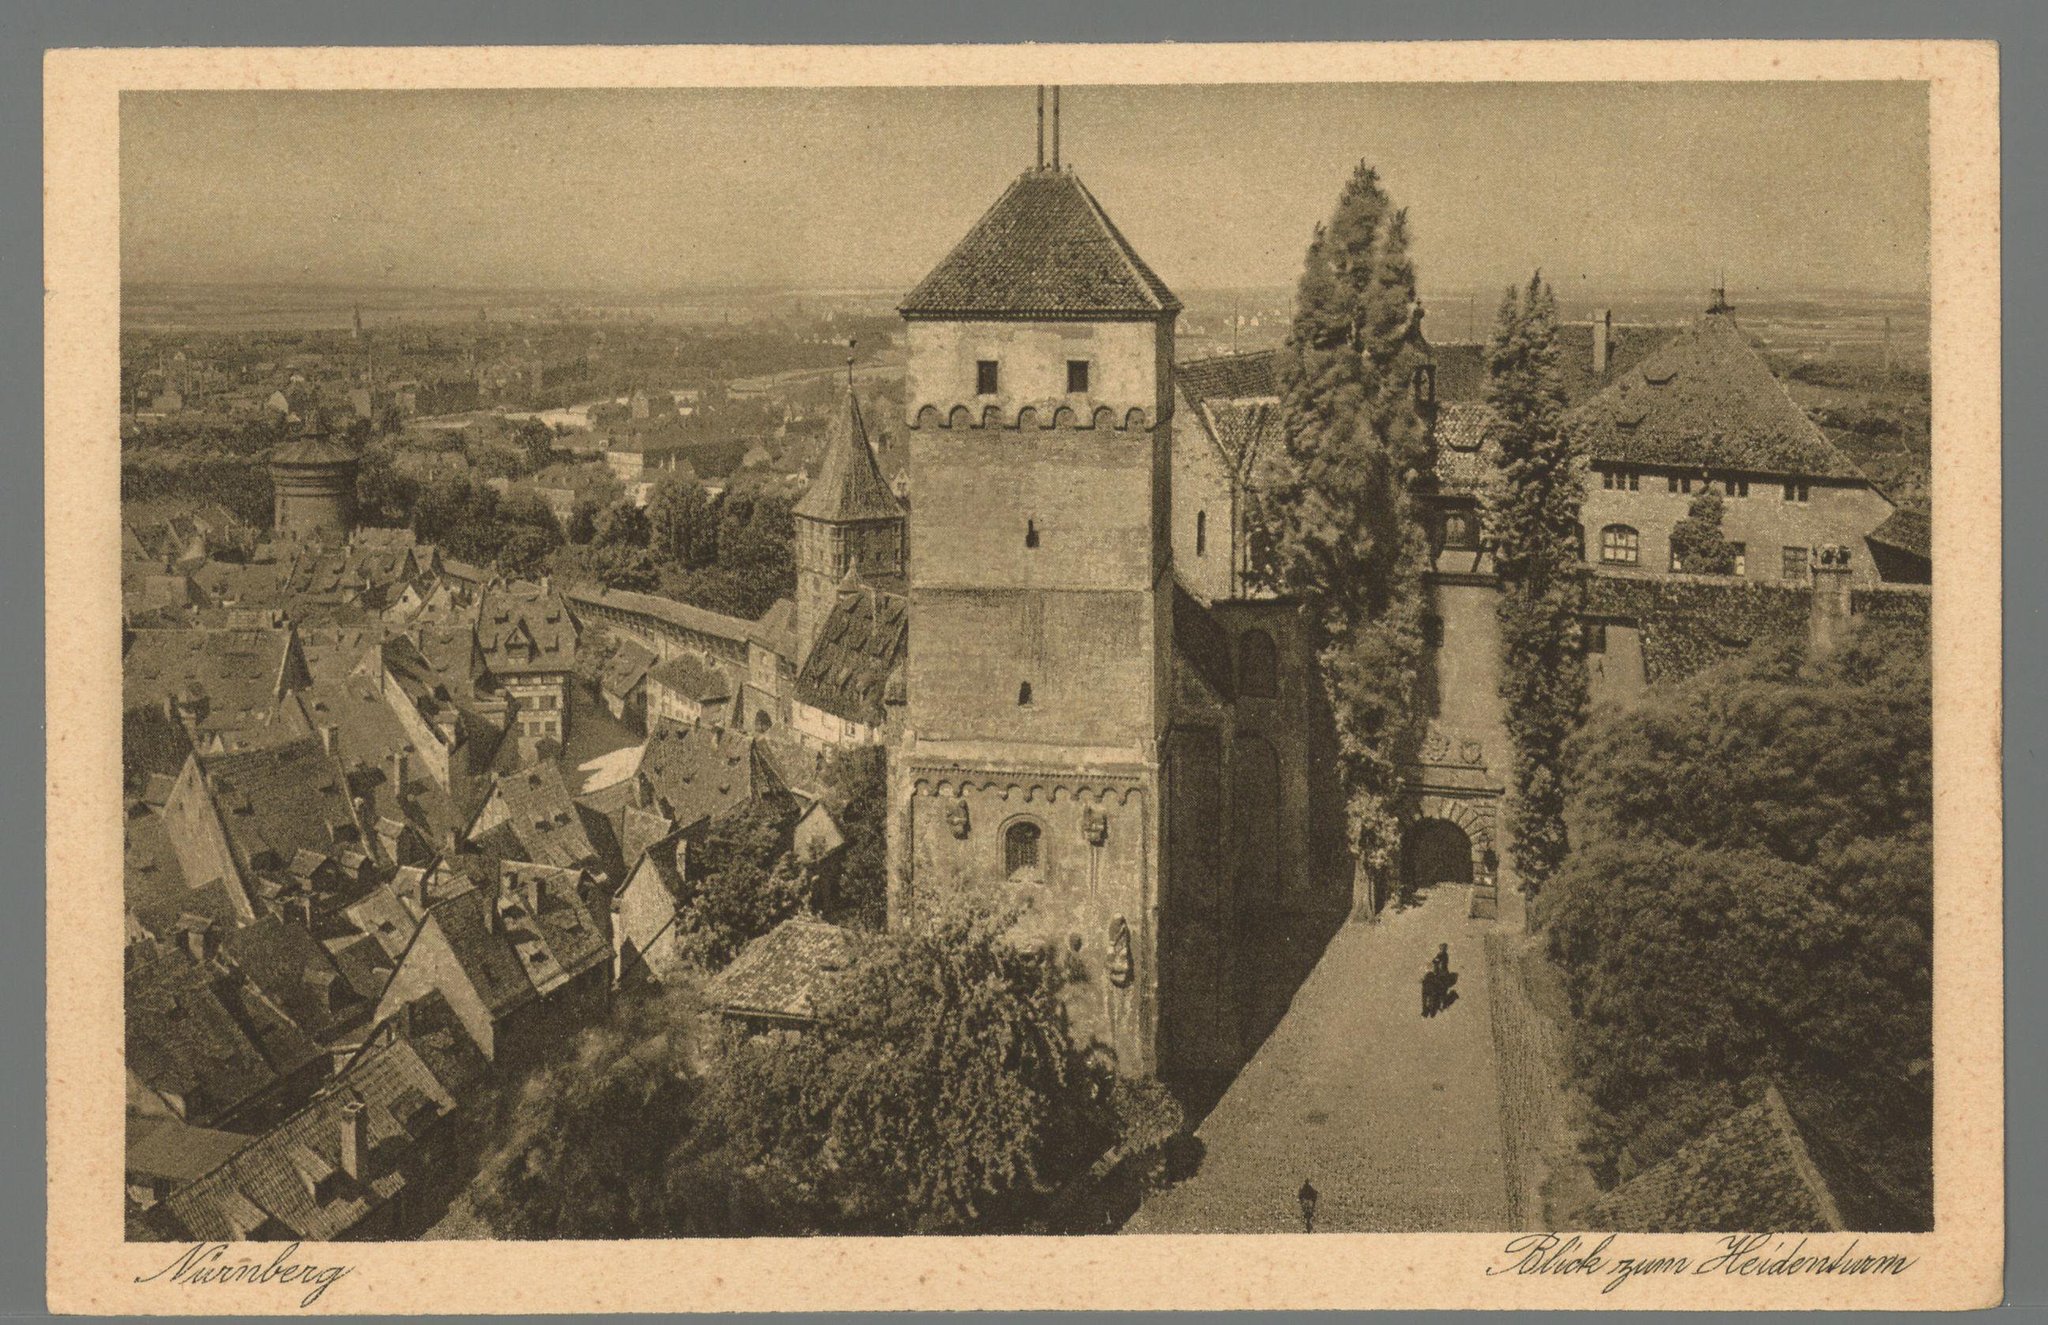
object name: ansichtkaart, prentbriefkaart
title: Nürnberg. Blick zum Heidenturm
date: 1905-1930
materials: cardboard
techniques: rotogravure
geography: nuremberg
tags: castle, towers ~ fortified city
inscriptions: inscription: ‘Riha Karte’